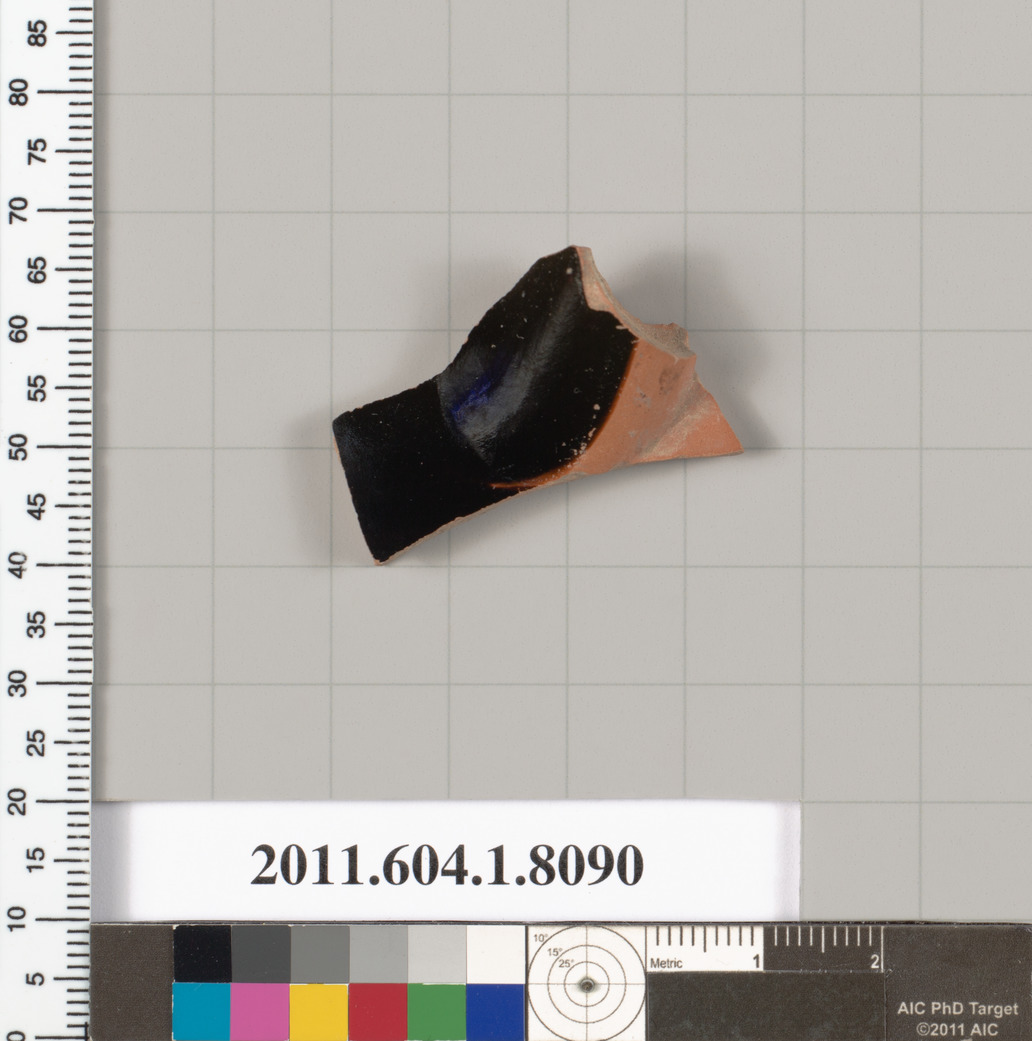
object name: kylix fragment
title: Terracotta fragment of a kylix (drinking cup)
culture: greek, attic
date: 510-500 BCE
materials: terracotta